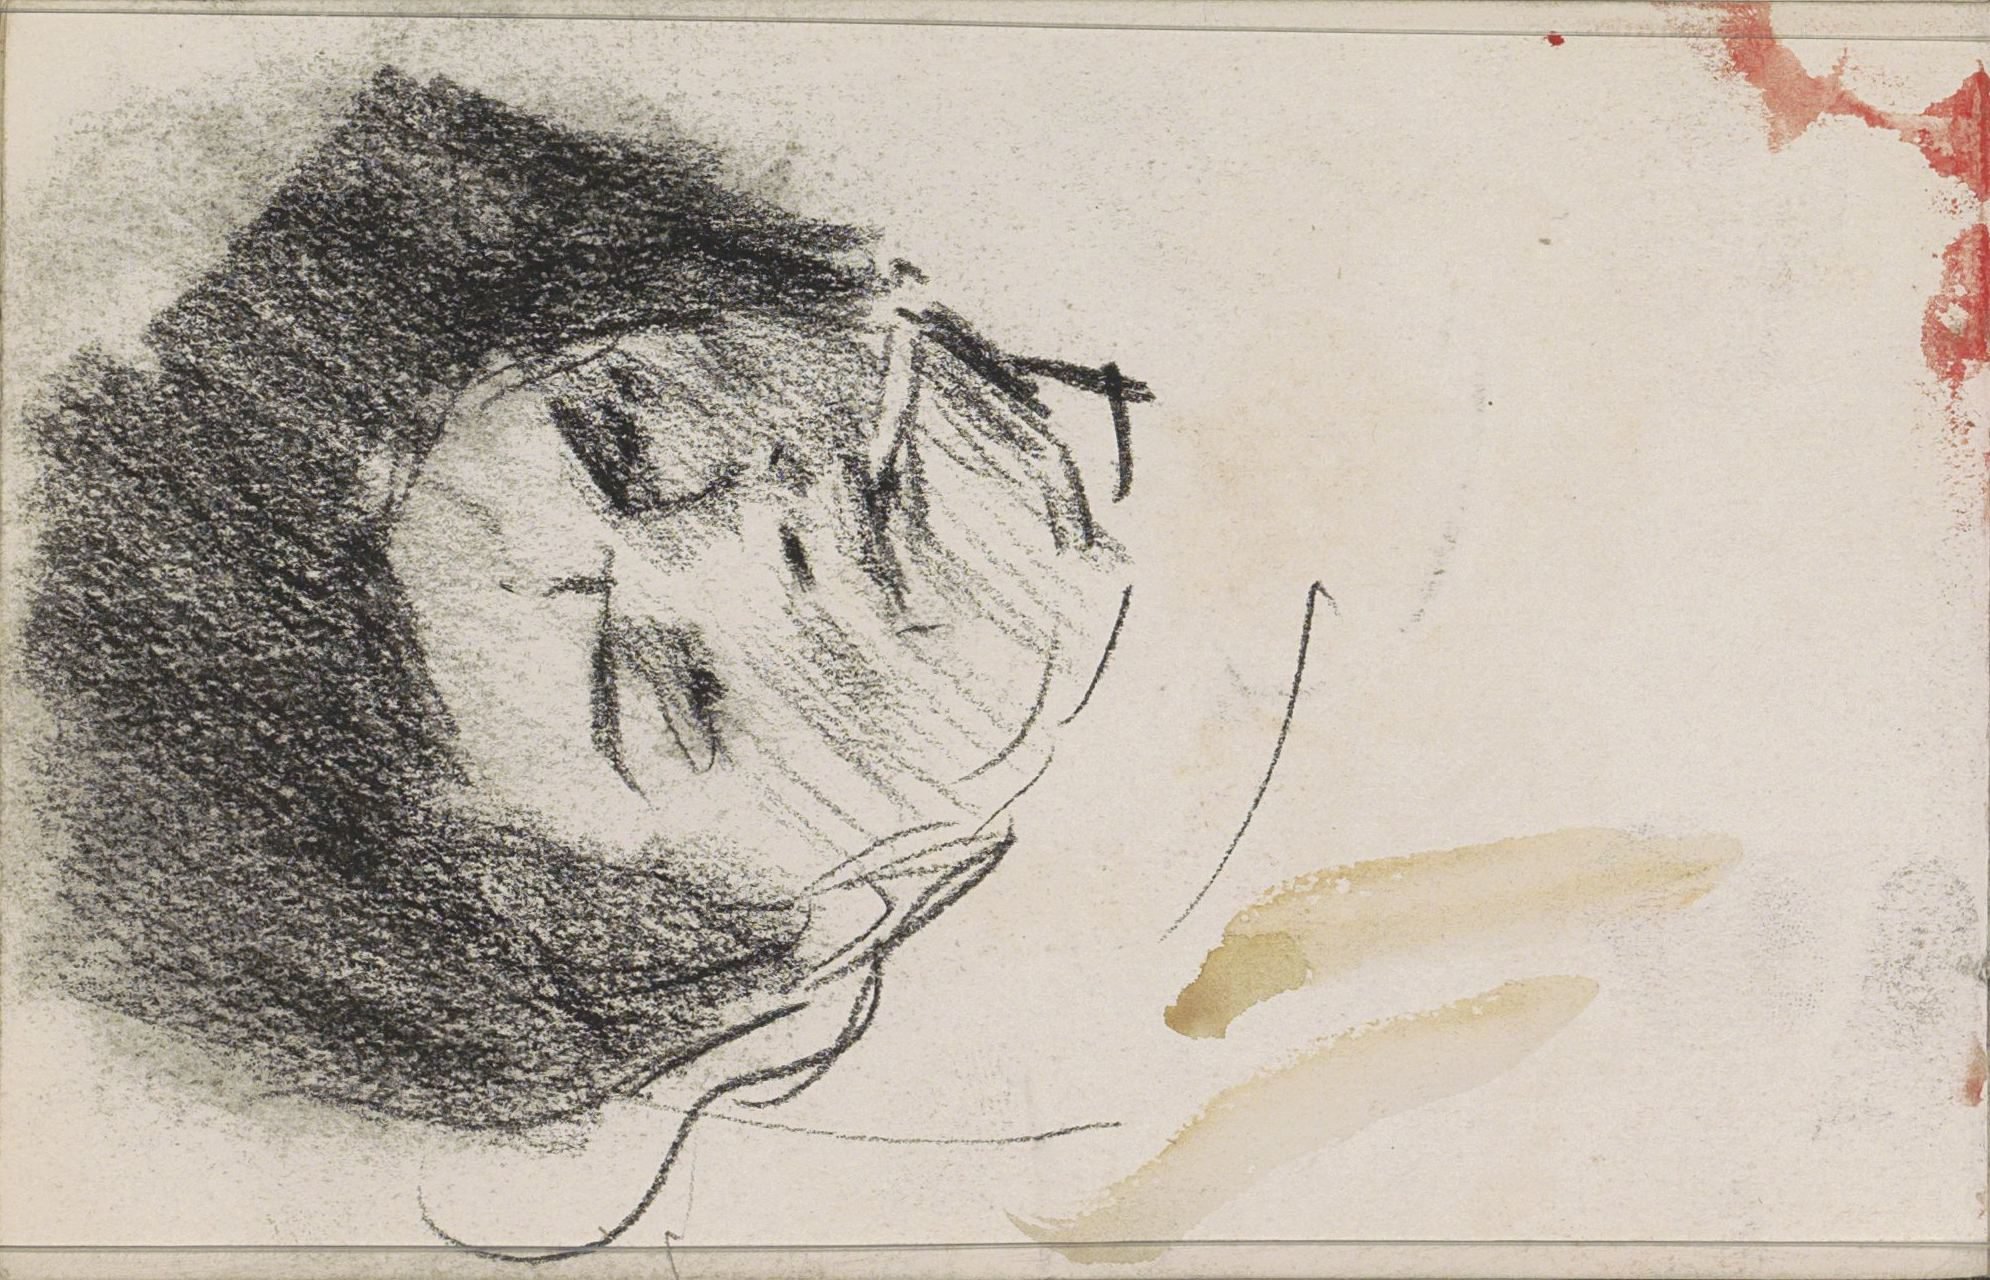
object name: sketchbook leaf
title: Vrouwenhoofd met sigaret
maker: isaac israels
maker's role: draughtsman, painter, print maker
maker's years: 1865-1934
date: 1887-1934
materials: chalk, paper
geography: paris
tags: head (human) - aa - female human figure, cigarette (+ taking (particular) foodstuffs: eating, drinking, smoking, chewing, etc.)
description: Pagina 25 uit schetsboek XLIX met 32 pagina's.